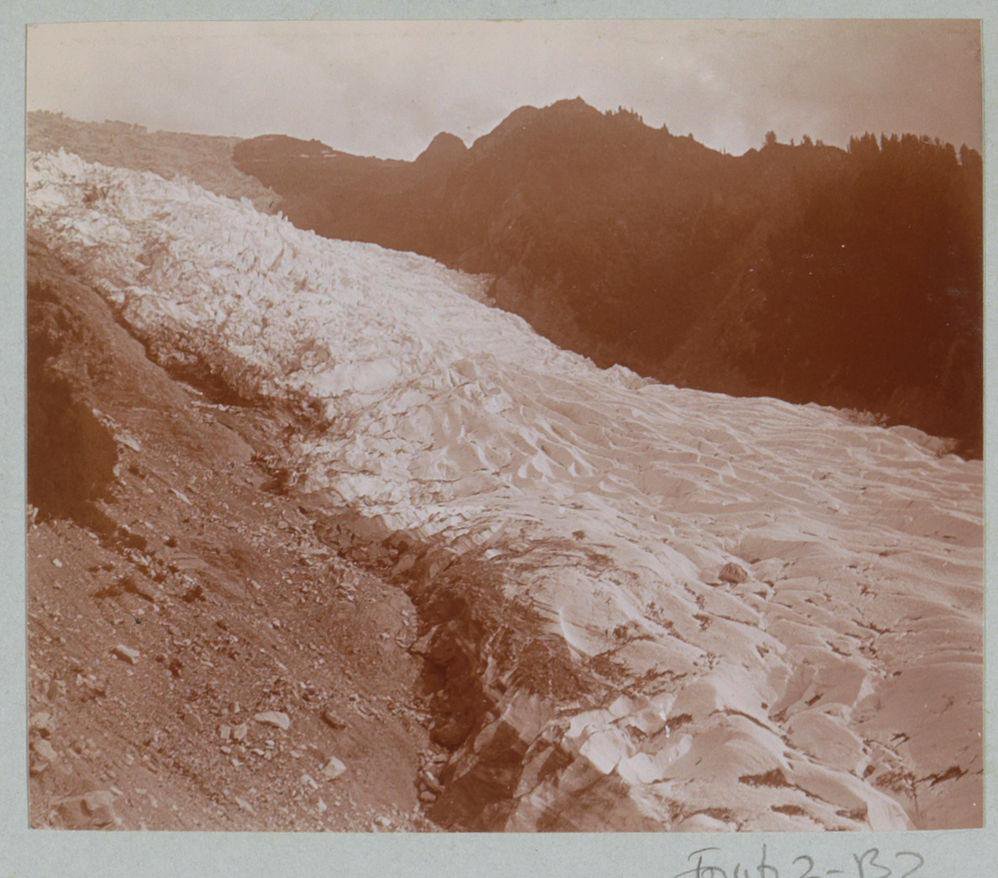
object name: photograph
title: Gezicht op een gletsjer in de Alpen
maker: Anonymous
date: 1905-1910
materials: paper, photographic support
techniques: gelatin silver print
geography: alps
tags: glacier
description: Onderdeel van Fotoalbum van een Franse amateurfotograaf met bezienswaardigheden in Frankrijk, Zwitserland en Italië.